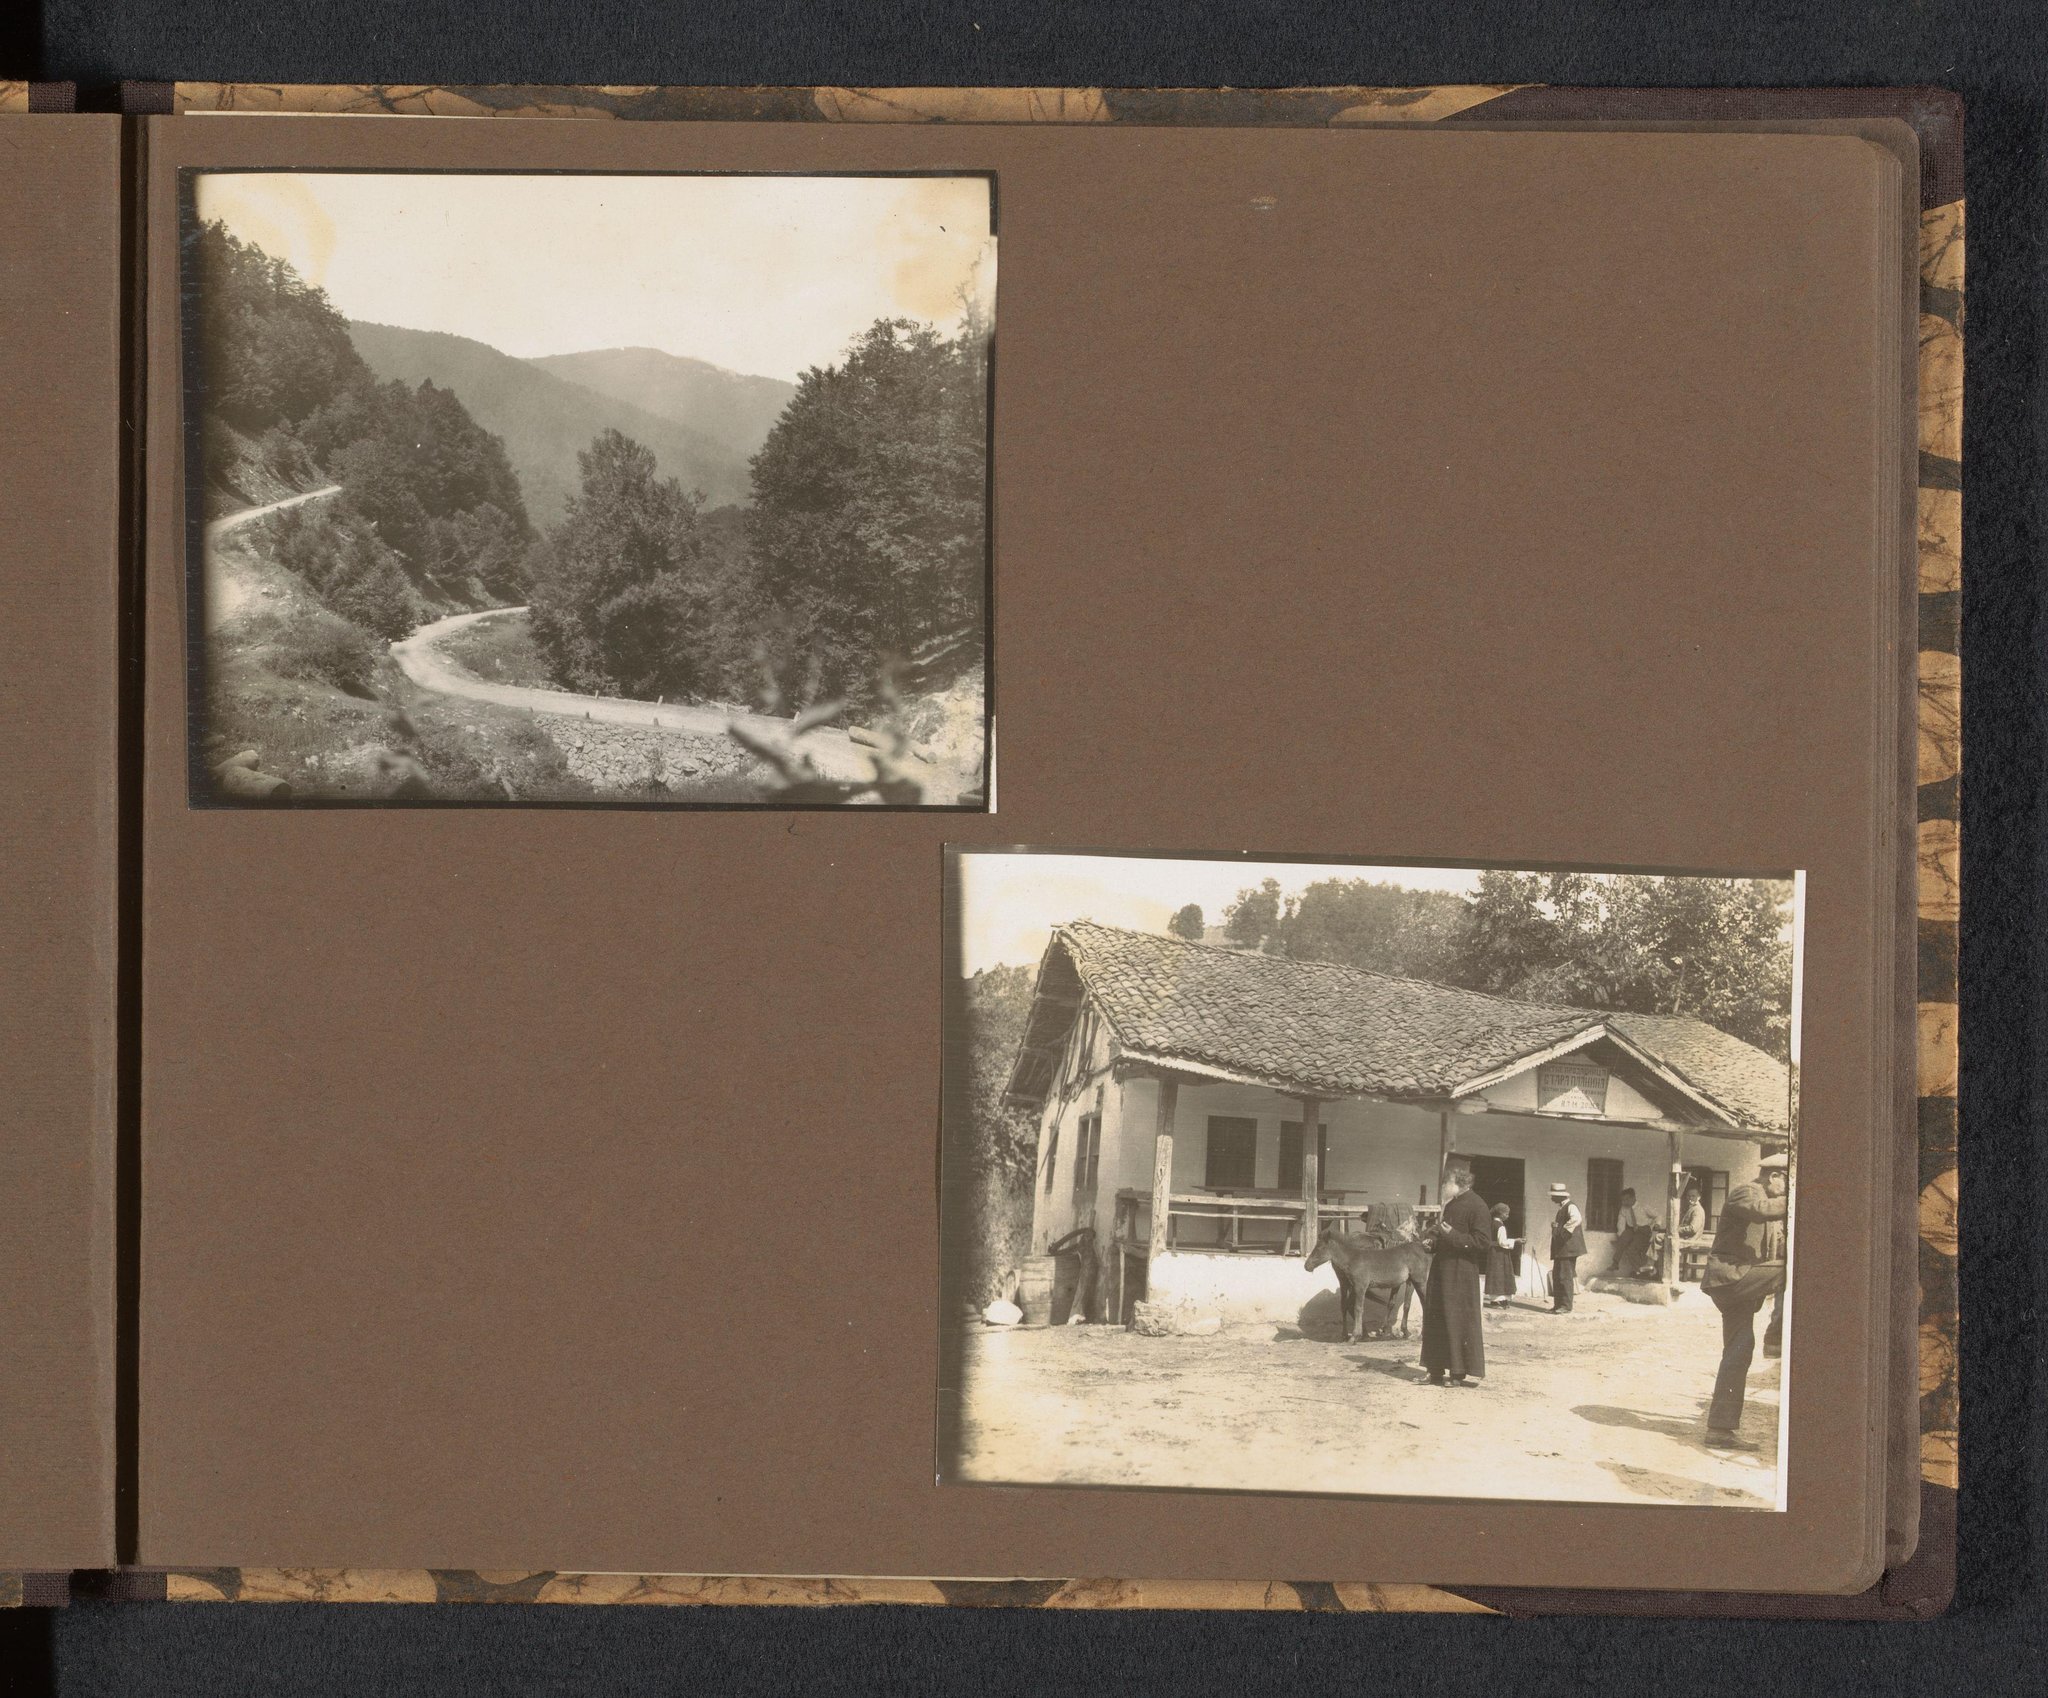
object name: album leaf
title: Bulgaarse natuur, tijdens een rondreis van Else Wachenheimer-Moos en haar echtgenoot Eugen Wachenheimer door Bulgarije, 1926-1927, Bulgarije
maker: else wachenheimer-moos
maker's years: 1895-1944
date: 1926-1927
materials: paper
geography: bulgaria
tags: bulgarije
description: Albumblad bevat twee foto's. Zonder personen gerelateerd aan de familie Wachenheimer. Afkomstig uit album half formaat, kartonomslag met koordbinding en lichte veelvormige vormen op voorzijde.